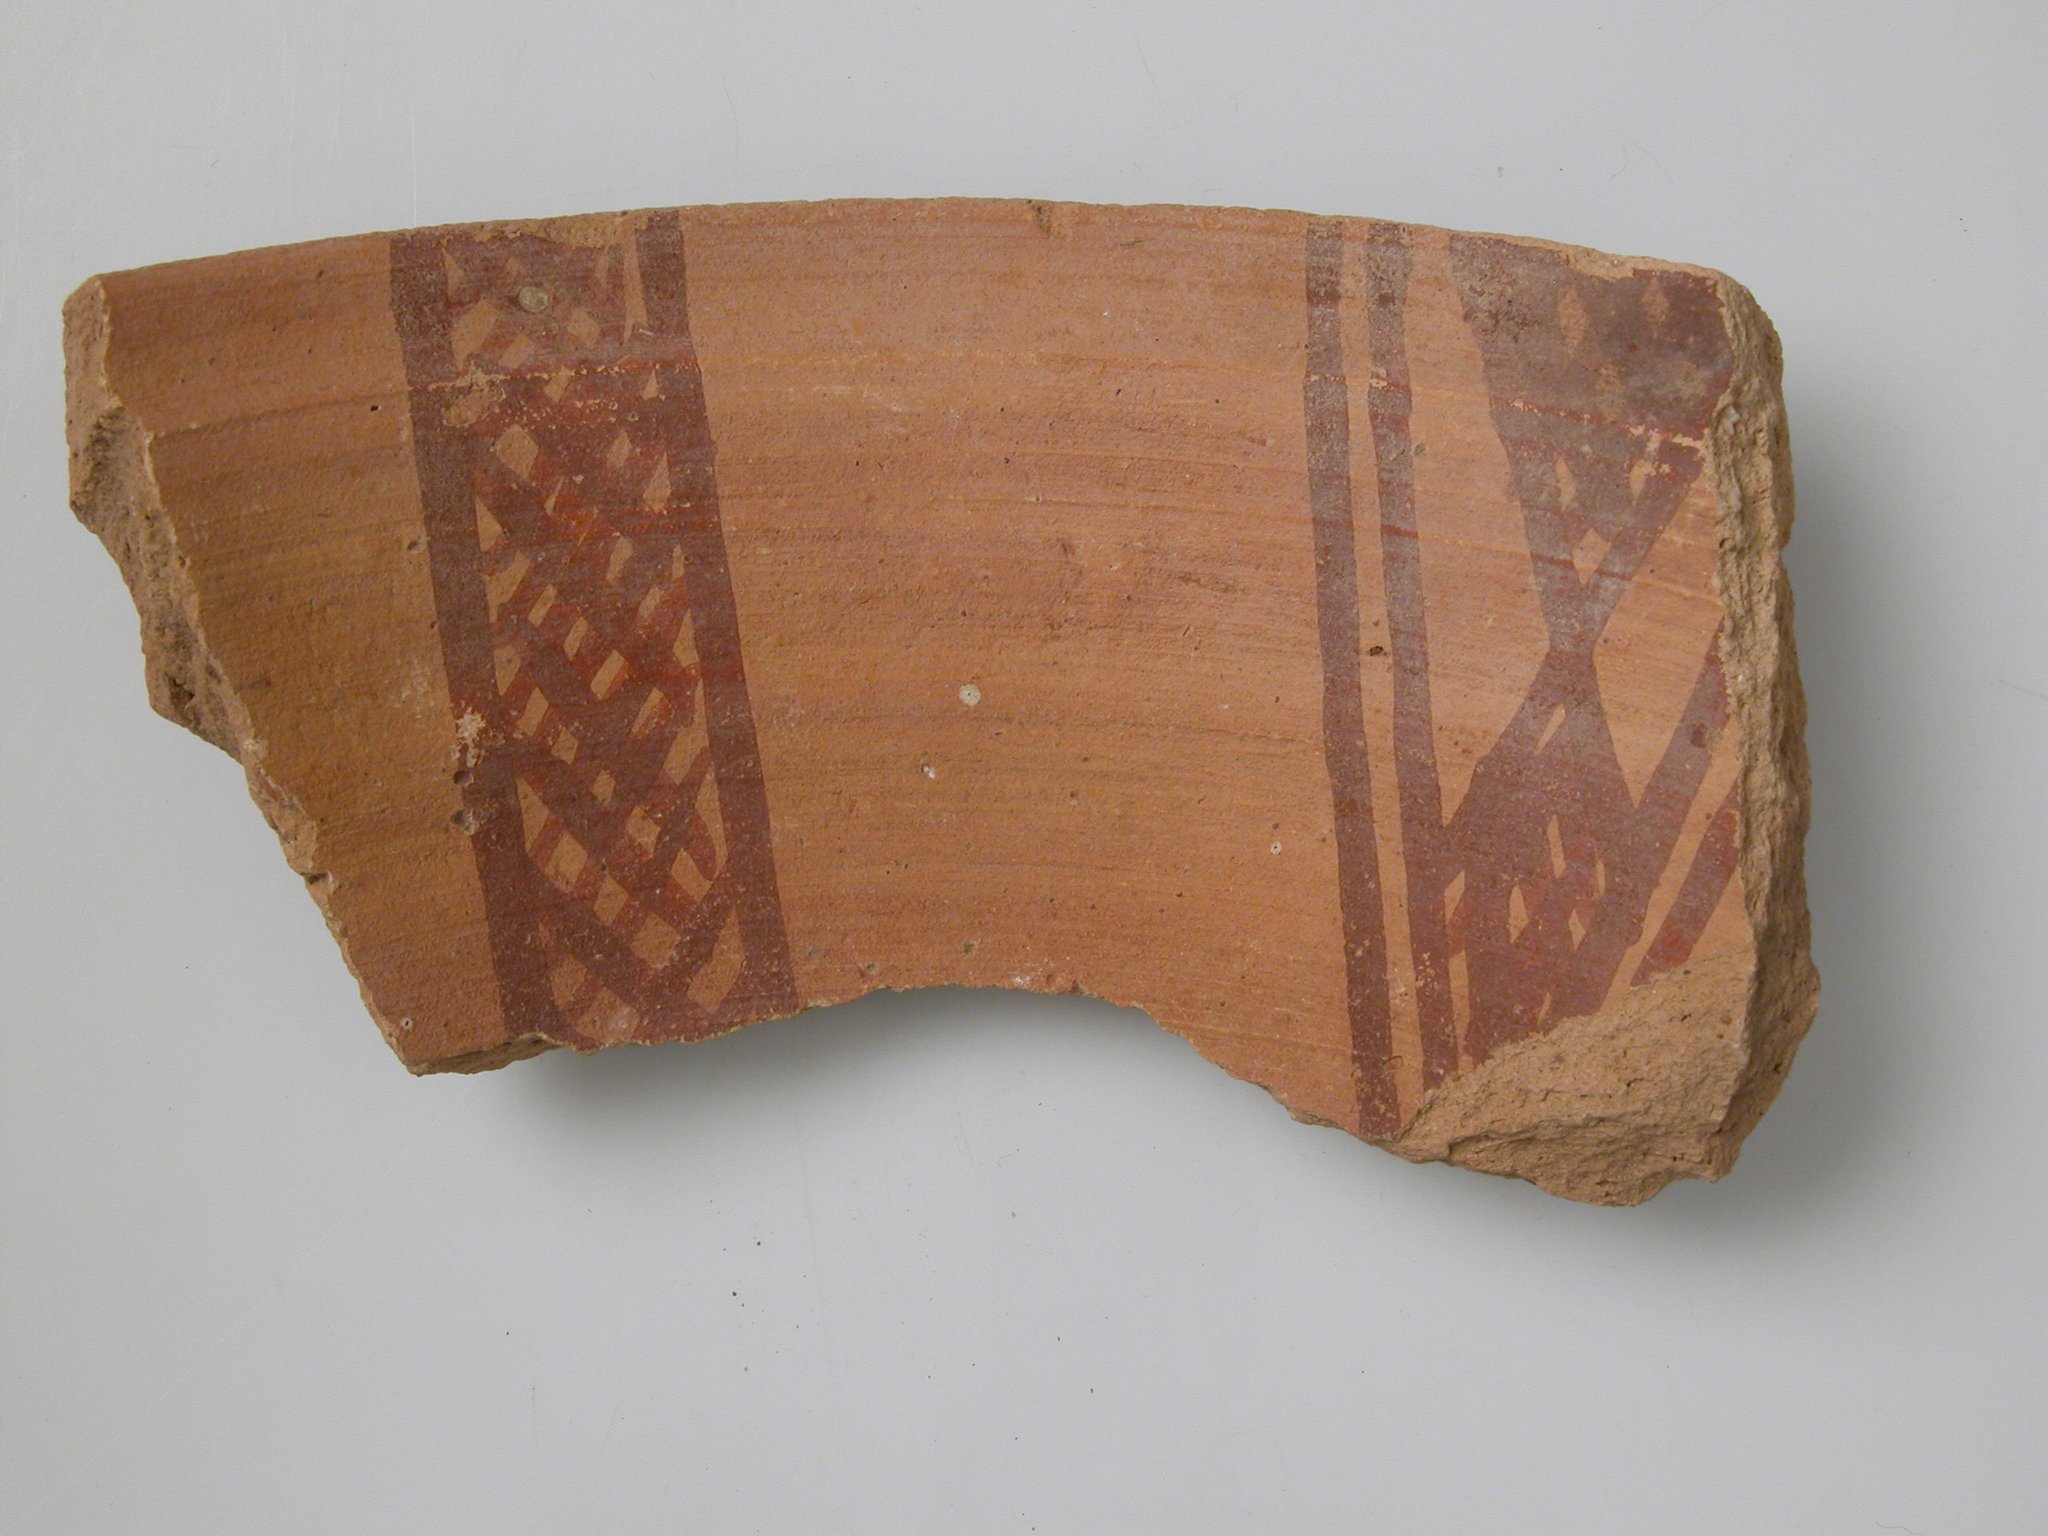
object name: fragment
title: Pot Fragment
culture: coptic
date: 301-700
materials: earthenware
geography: egypt